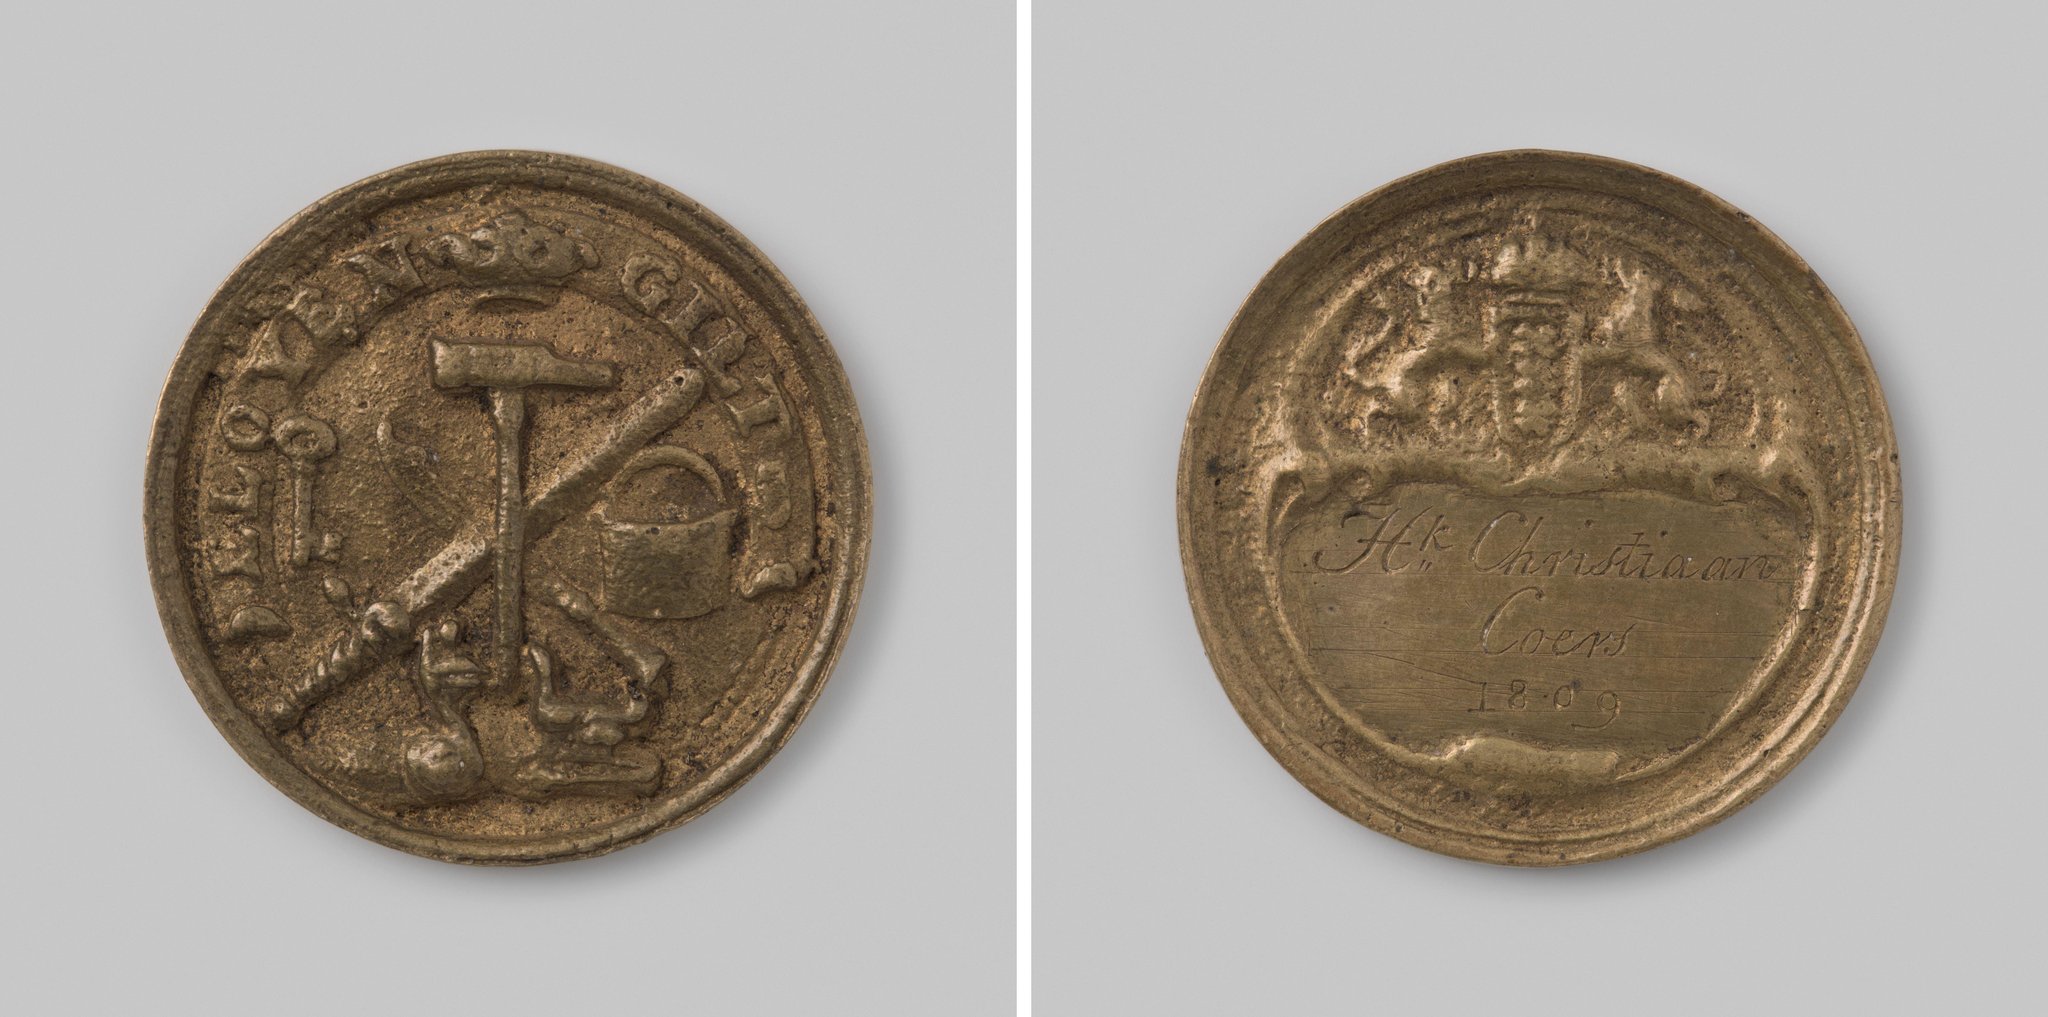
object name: medal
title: Gildepenning van het Smedengilde Sint Eloy te Amsterdam, op naam van Hk. Christiaan Coers.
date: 1718-1809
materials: brass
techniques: casting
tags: goldsmith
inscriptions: inscription: ‘Hk. Christiaan / Coers / 1809’, circumscription: ‘ELOYEN - GILT’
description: Gegoten messing penning van het Smidsgilde, op de voorzijde een compostitie van hamer, zwaard, mes, sleutel, ketel en geweerslot met omschrift, op de keerzijde een gekroond wapenschild van Amsterdam met dragers boven een inscriptieruimte, op naam van Hk. Christiaan Coers 1809